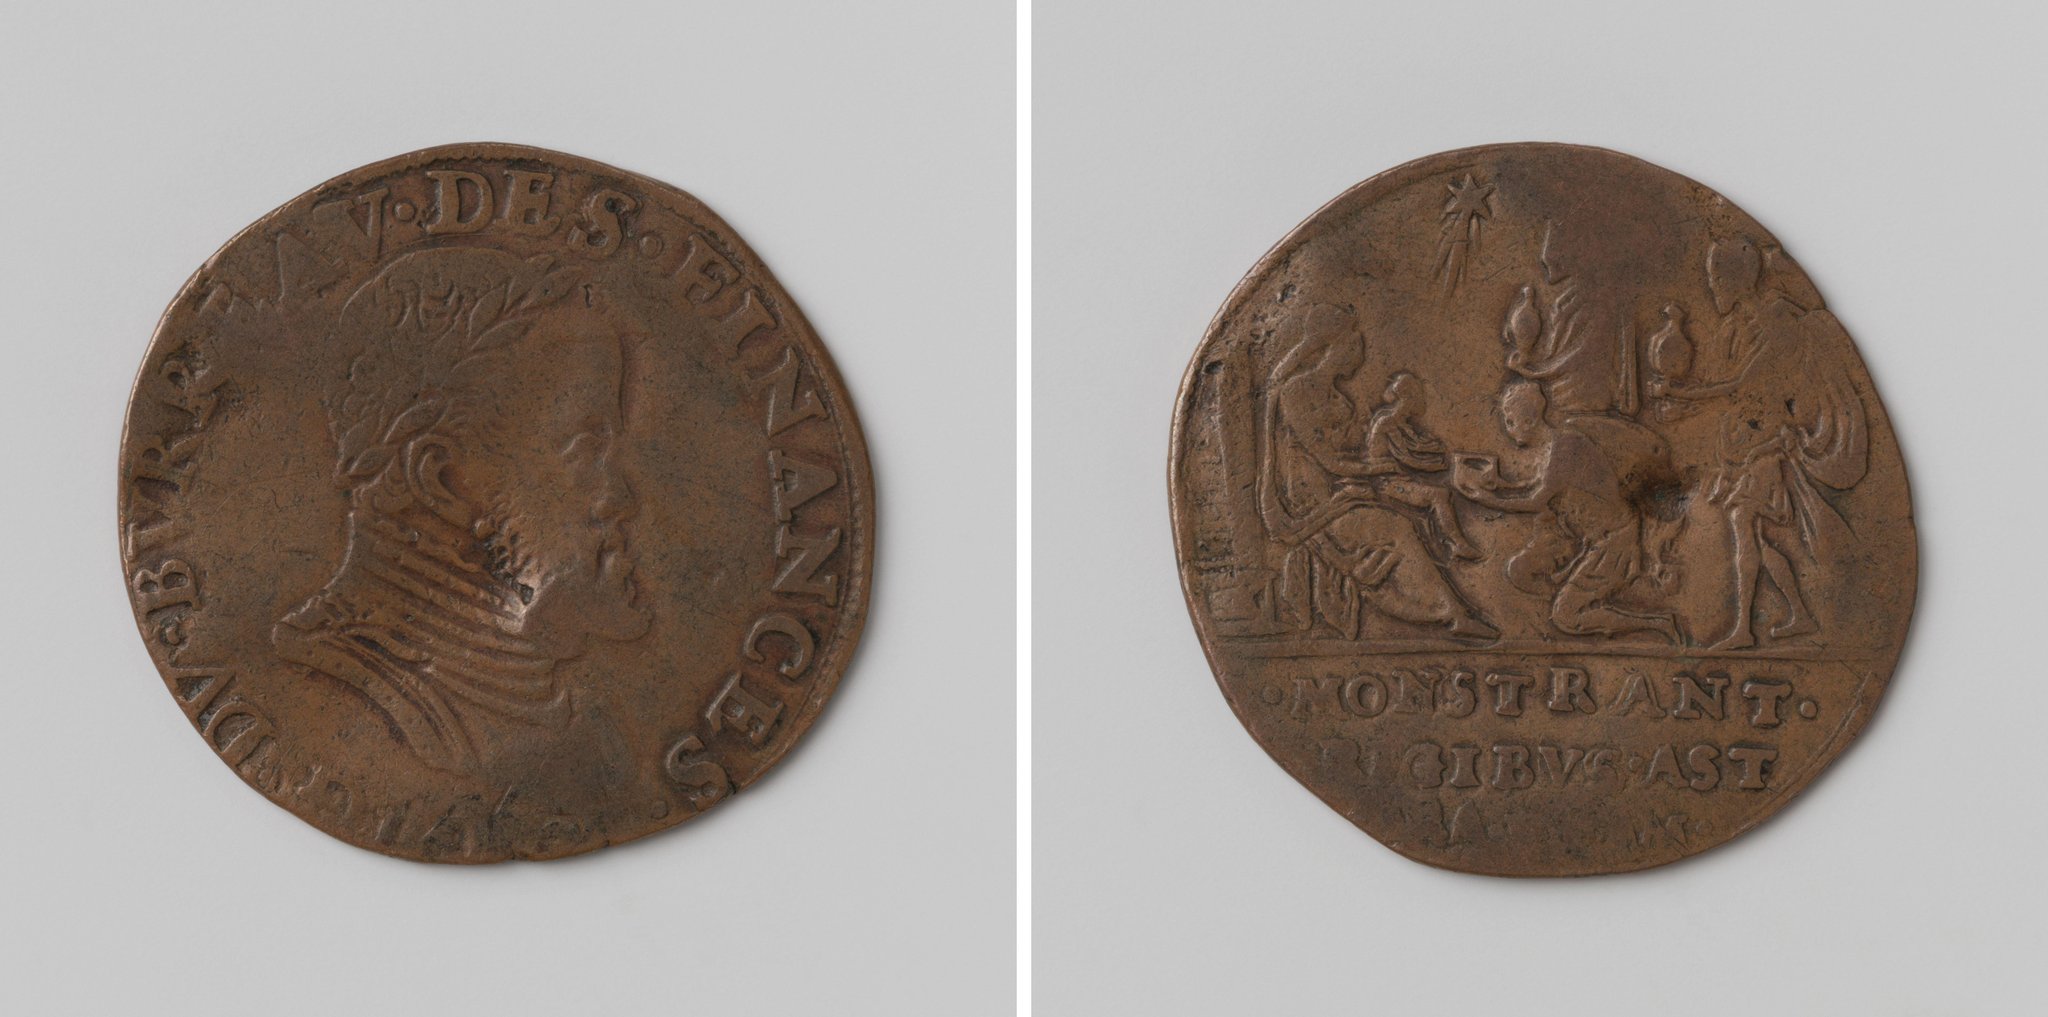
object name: jeton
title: Filips II, koning van Spanje, rekenpenning van de raad van Financiën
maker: Anonymous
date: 1562-1563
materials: copper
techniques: striking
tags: philip ii of spain